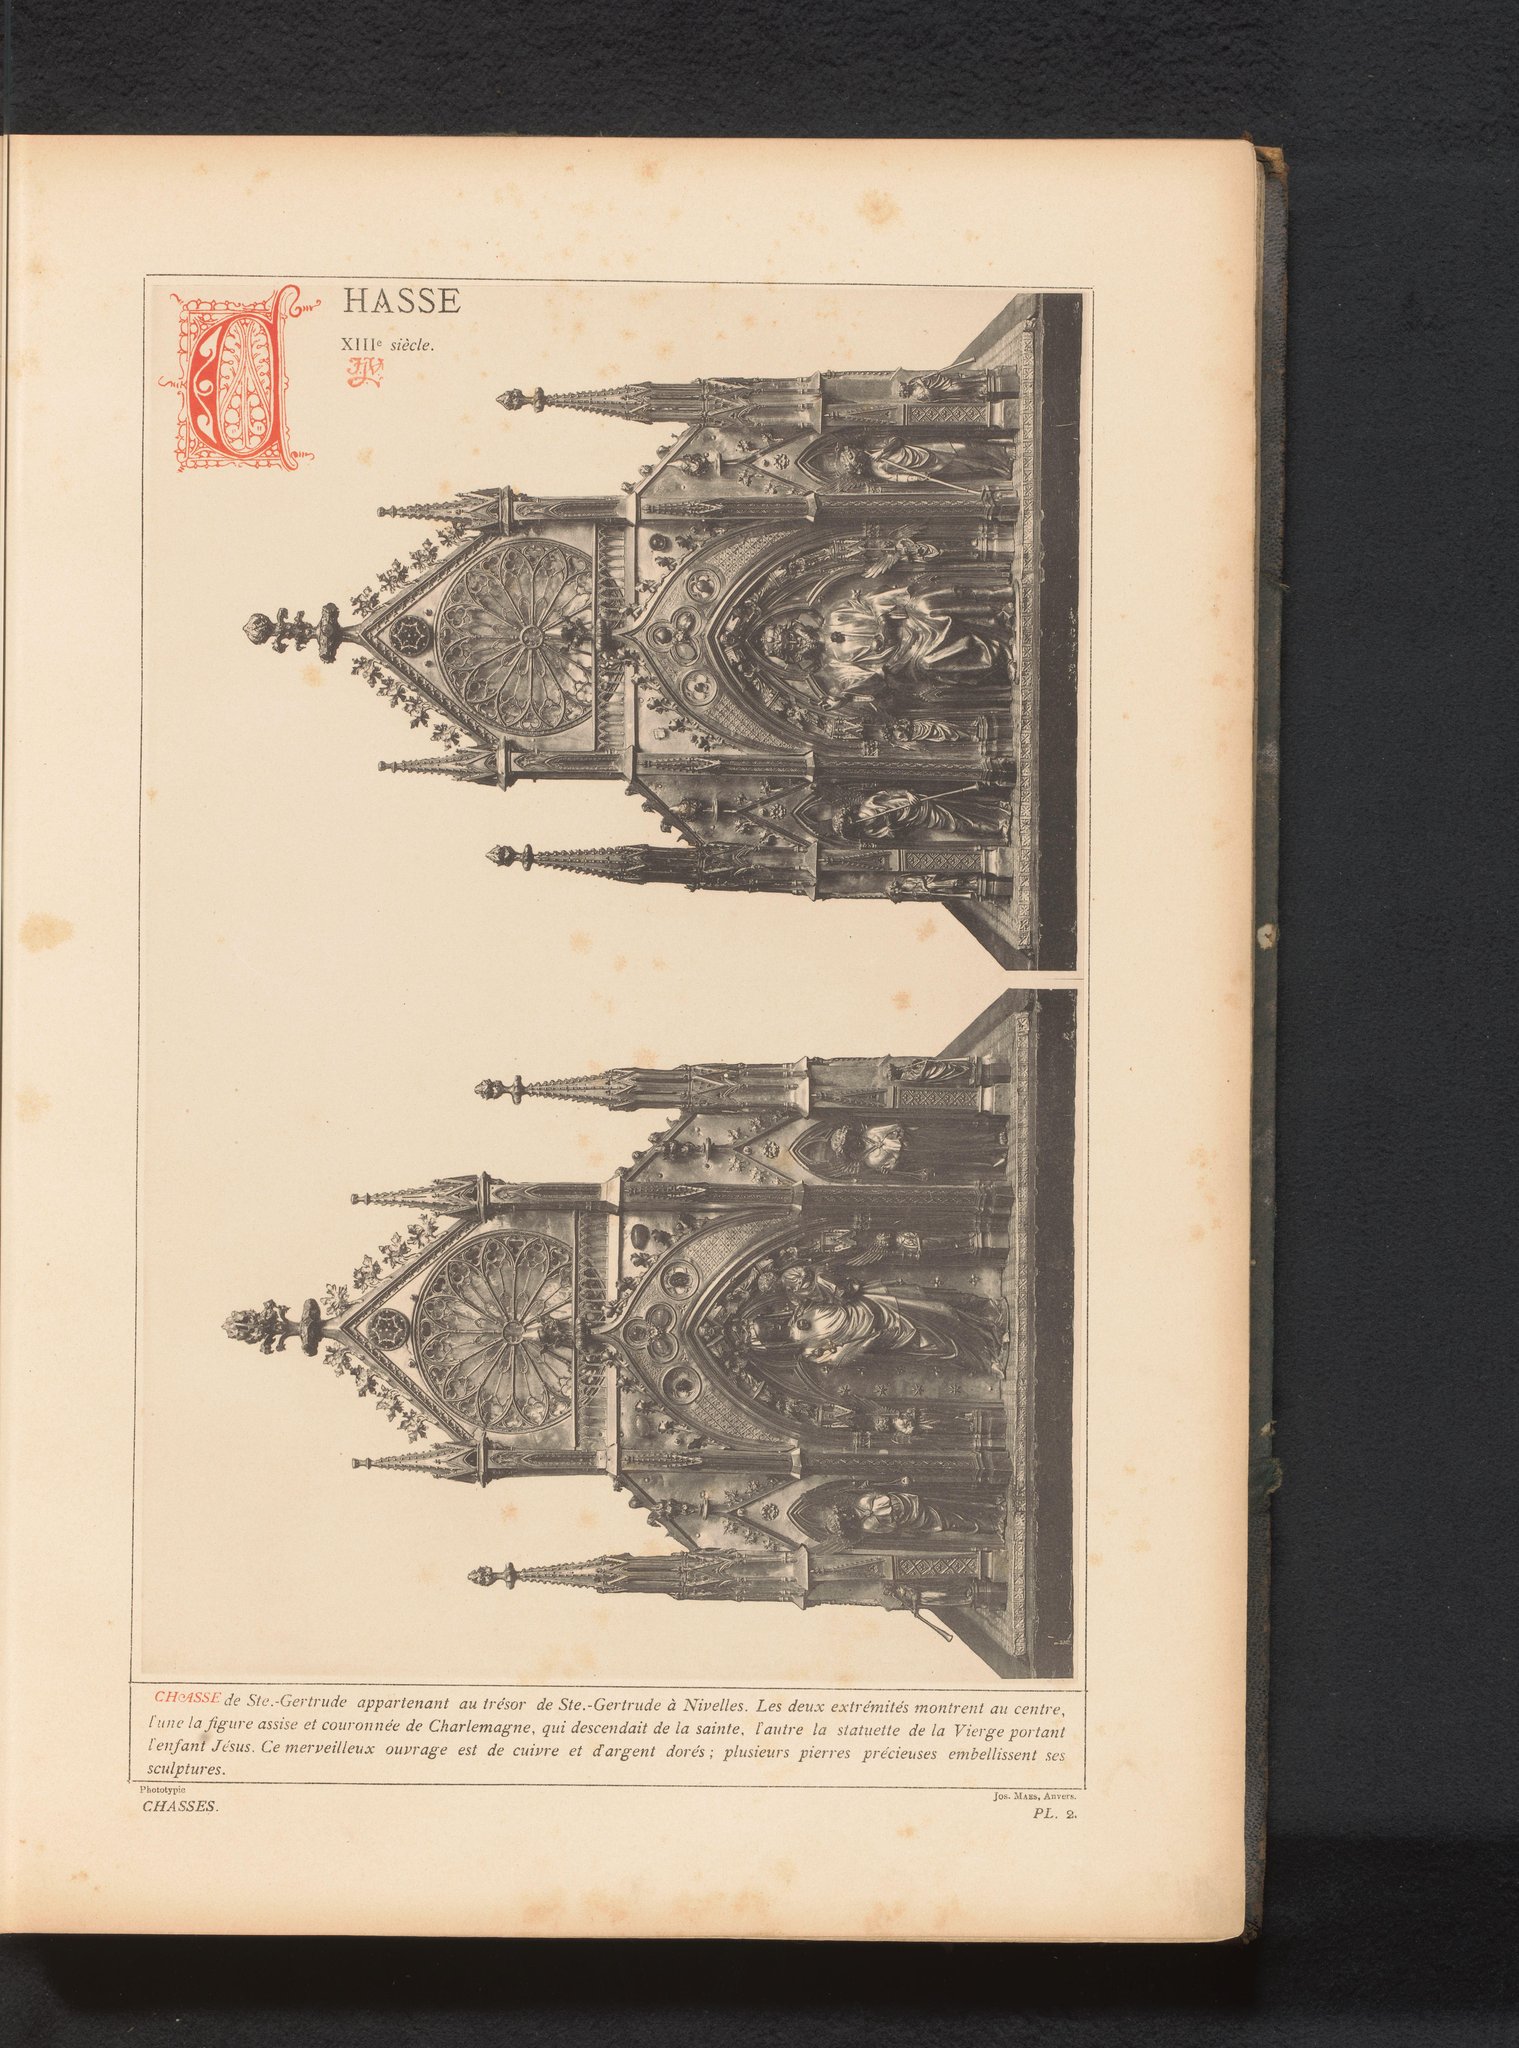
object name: page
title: Chasse, XIIIe siècle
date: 1882-1887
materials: paper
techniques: photograph, photolithography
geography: antwerp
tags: relics (and reliquaries), the abbess gertrude of nivelles; possible attributes: book, pastoral staff, crown, cup, demon, mouse or mice, model of church or hospital, palm, (healing) well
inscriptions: inscription: ‘CHASSE de Ste.-Gertrude (...)’, inscription: ‘CHASSES. - PL. 2.’, monogram: ‘JJvY’